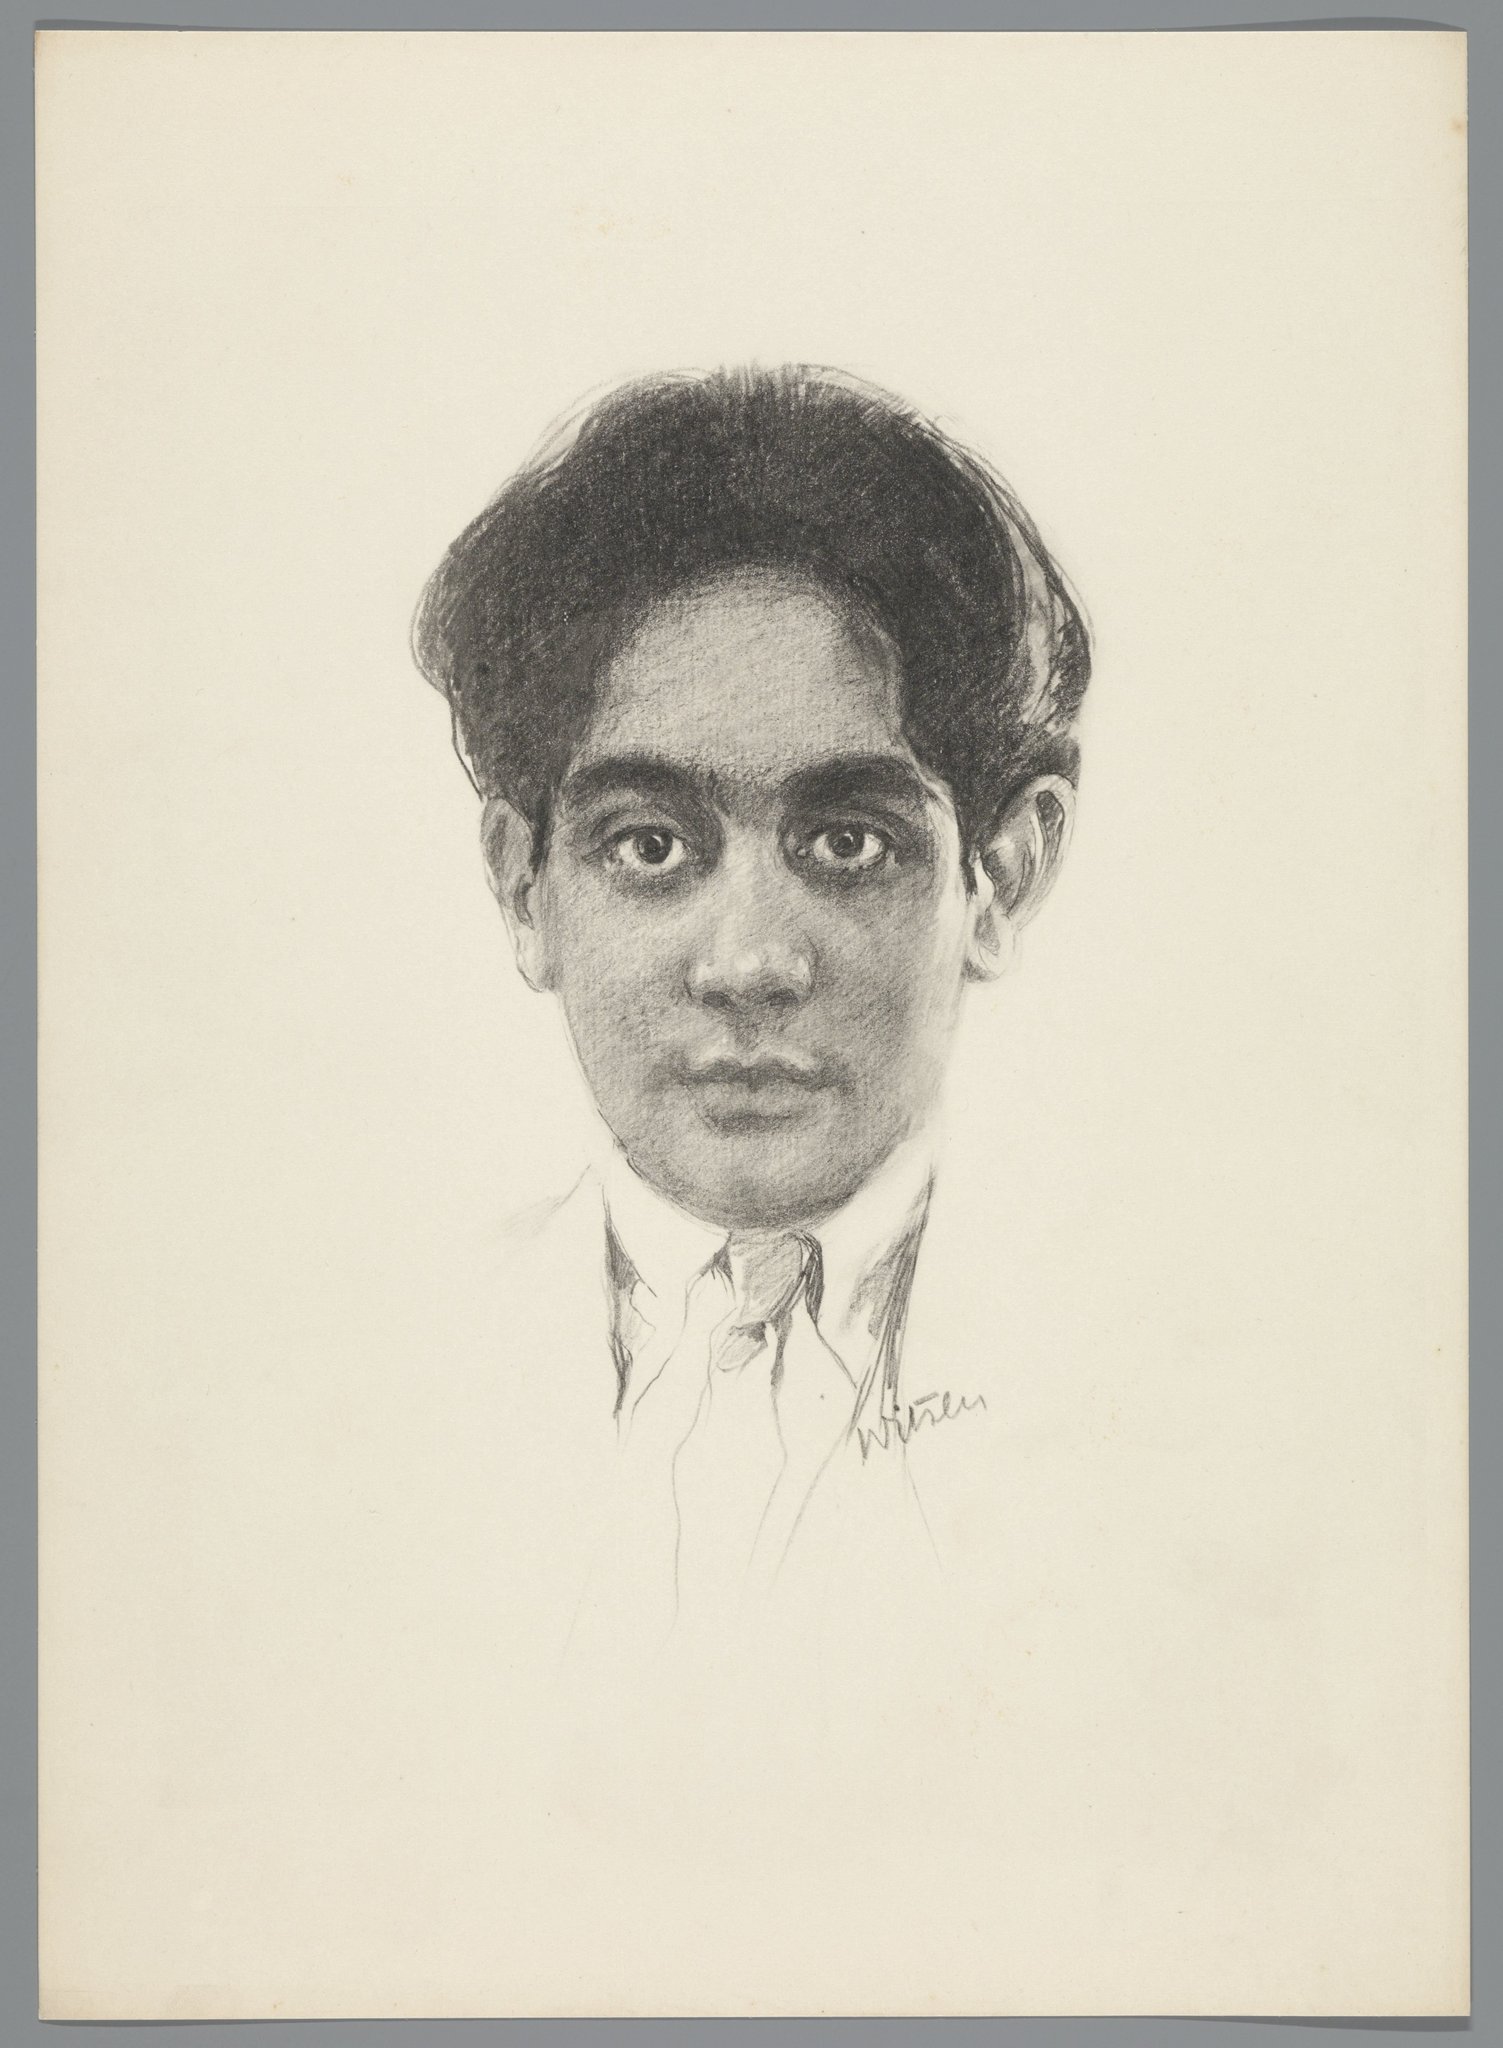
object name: photomechanical print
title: Reproductie van tekening met portret van Karamjit Singh Sahib Bahadur, prins van Kapurthala, door Willem Witsen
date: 1915-1916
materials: paper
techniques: photograph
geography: netherlands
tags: politician, historical persons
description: Voor schilderij van de geportretteerde door Witsen, zie collectie Dordrechts Museum (bruikleen RCE).